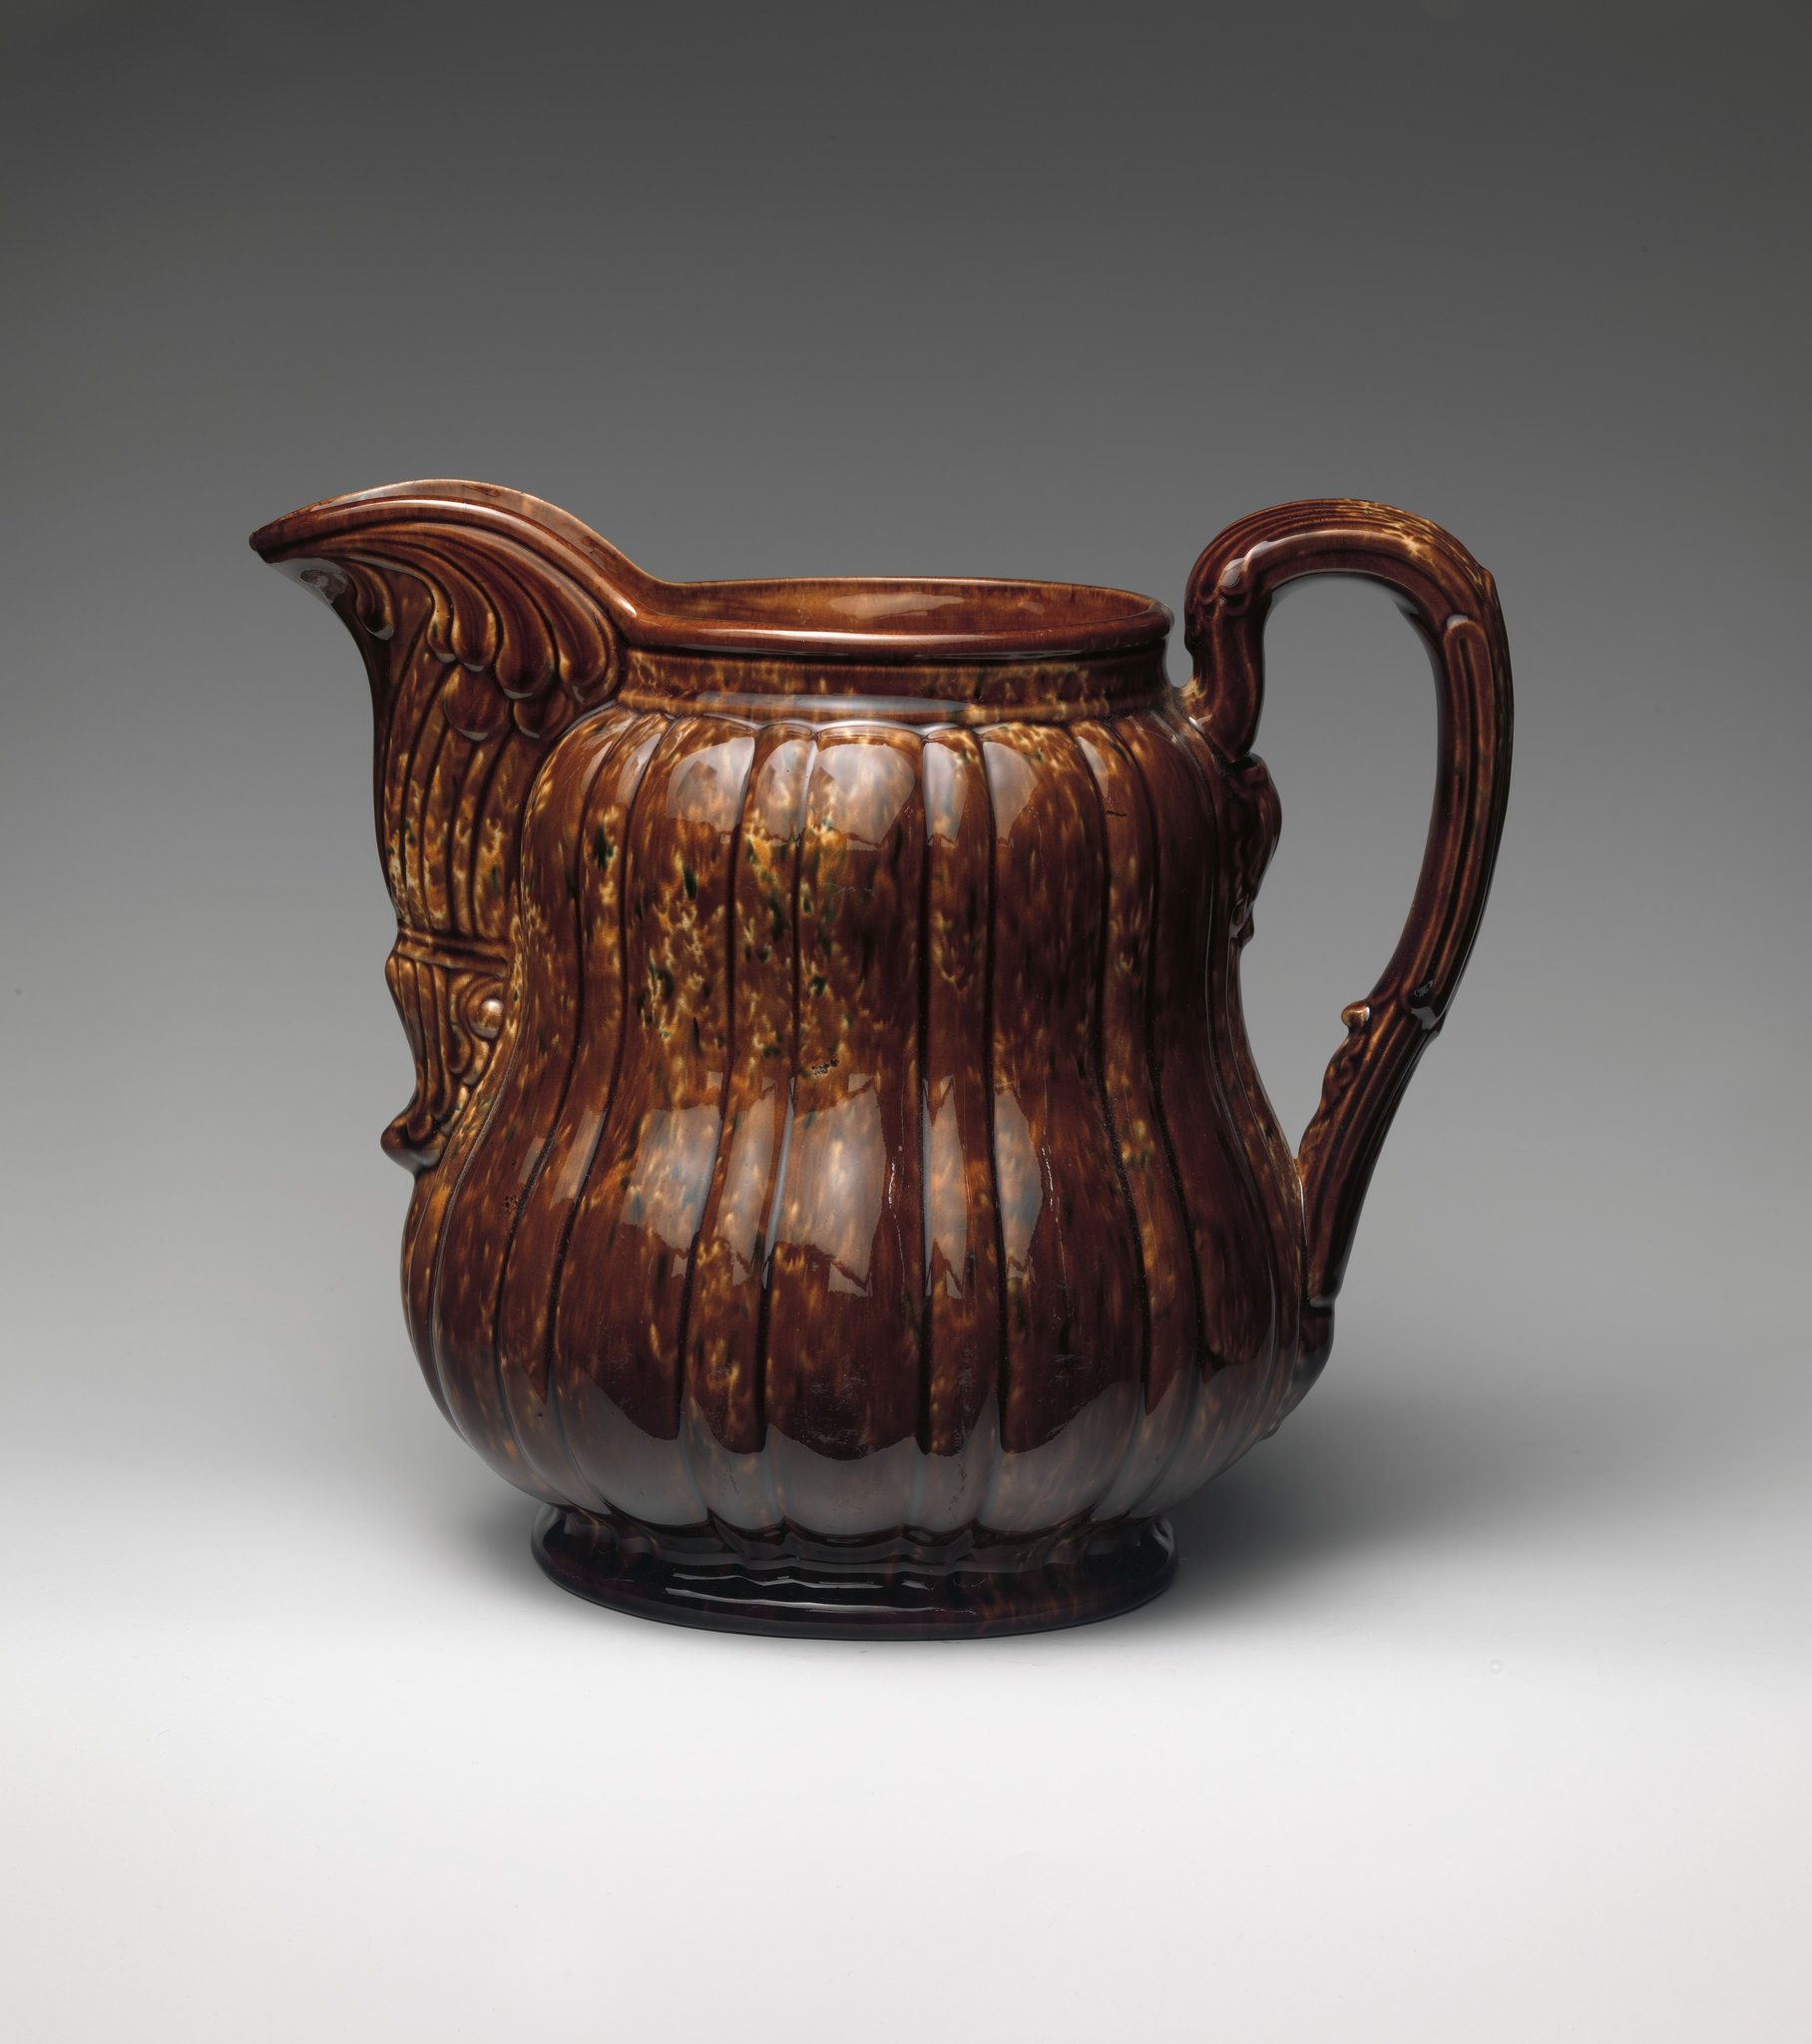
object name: pitcher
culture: american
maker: united states pottery company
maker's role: maker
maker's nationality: american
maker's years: 1852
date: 1849-1858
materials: earthenware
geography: united states